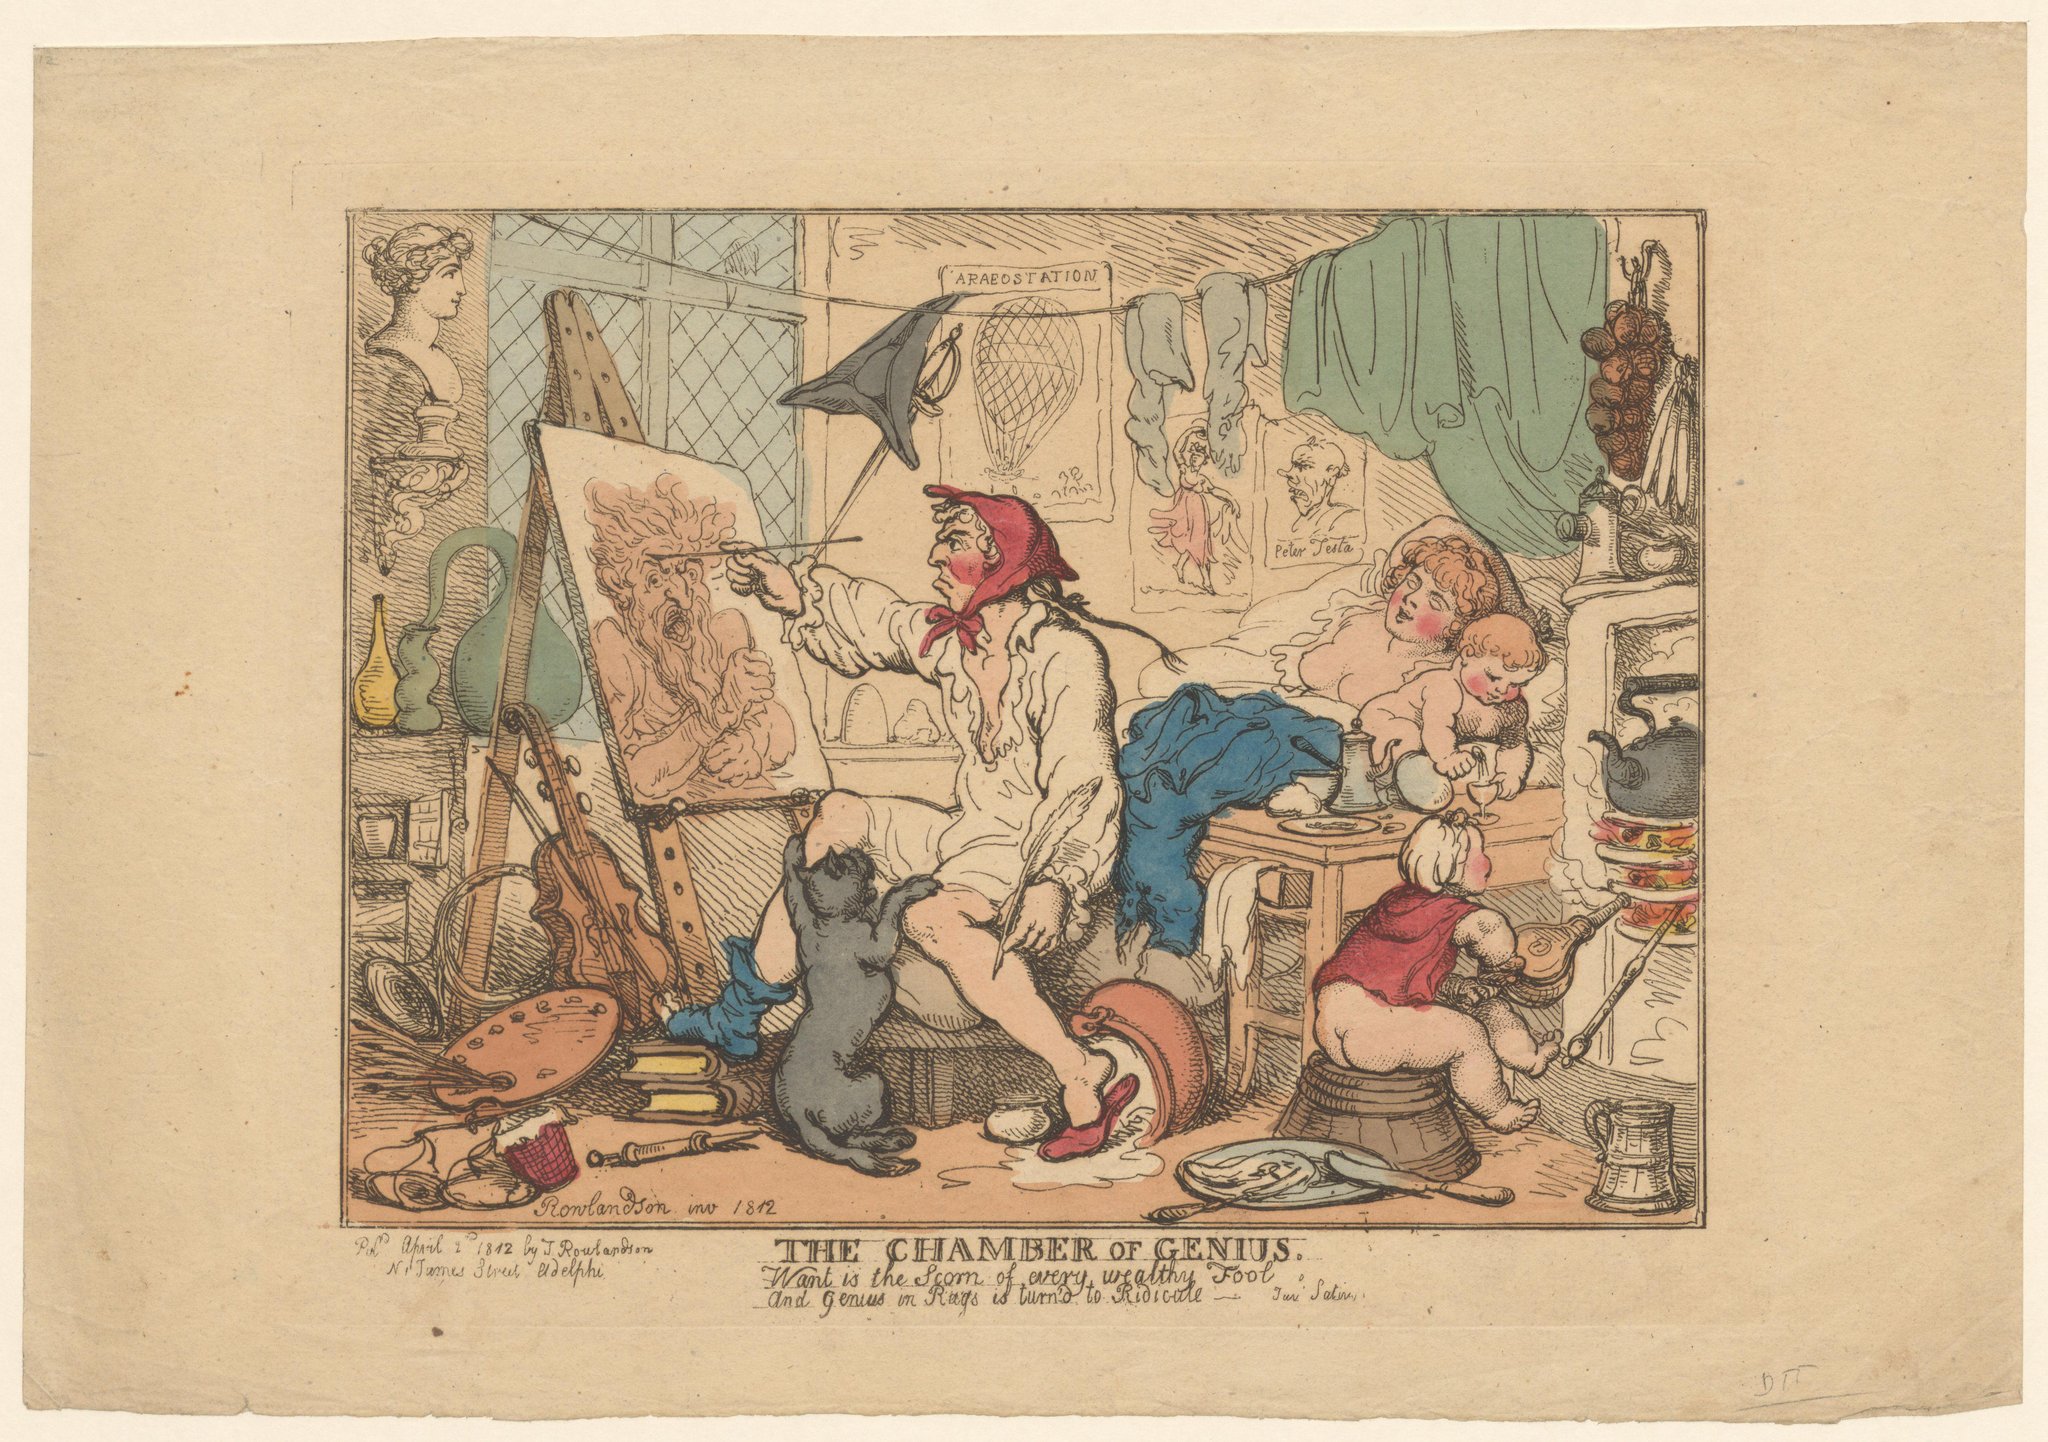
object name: cartoon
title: The Chamber of Genius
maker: thomas rowlandson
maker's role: draughtsman, print maker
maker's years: 1756-1827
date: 1812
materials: paper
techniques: etching, hand coloring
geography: london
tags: inspiration of the artist (in general), artist in non-work situation, 'genio' (ripa)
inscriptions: collector's mark: Lugt 2760, collector's mark: Lugt 2228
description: Onderaan tekst in het Engels: 'Want is the scorn of every wealthy fool, and genius in rags is turn'd to ridicule'. De kunstenaar richt zich in geconcentreerde frustratie op zijn schilderij. Onachtzaam op zichzelf en zijn omgeving. Objecten van verschillende kunstvormen liggen om hem heen. Op de muur drie prenten, mogelijk een verwijzing naar een andere prent door Thomas Rowlandson 'Aerostation out at elbows or the itinerant aeronaut'. Achter hem ligt zijn vrouw half ontbloot te slapen terwijl een baby wijn inschenkt en het andere kind vuur opstookt met een blaasbalg.